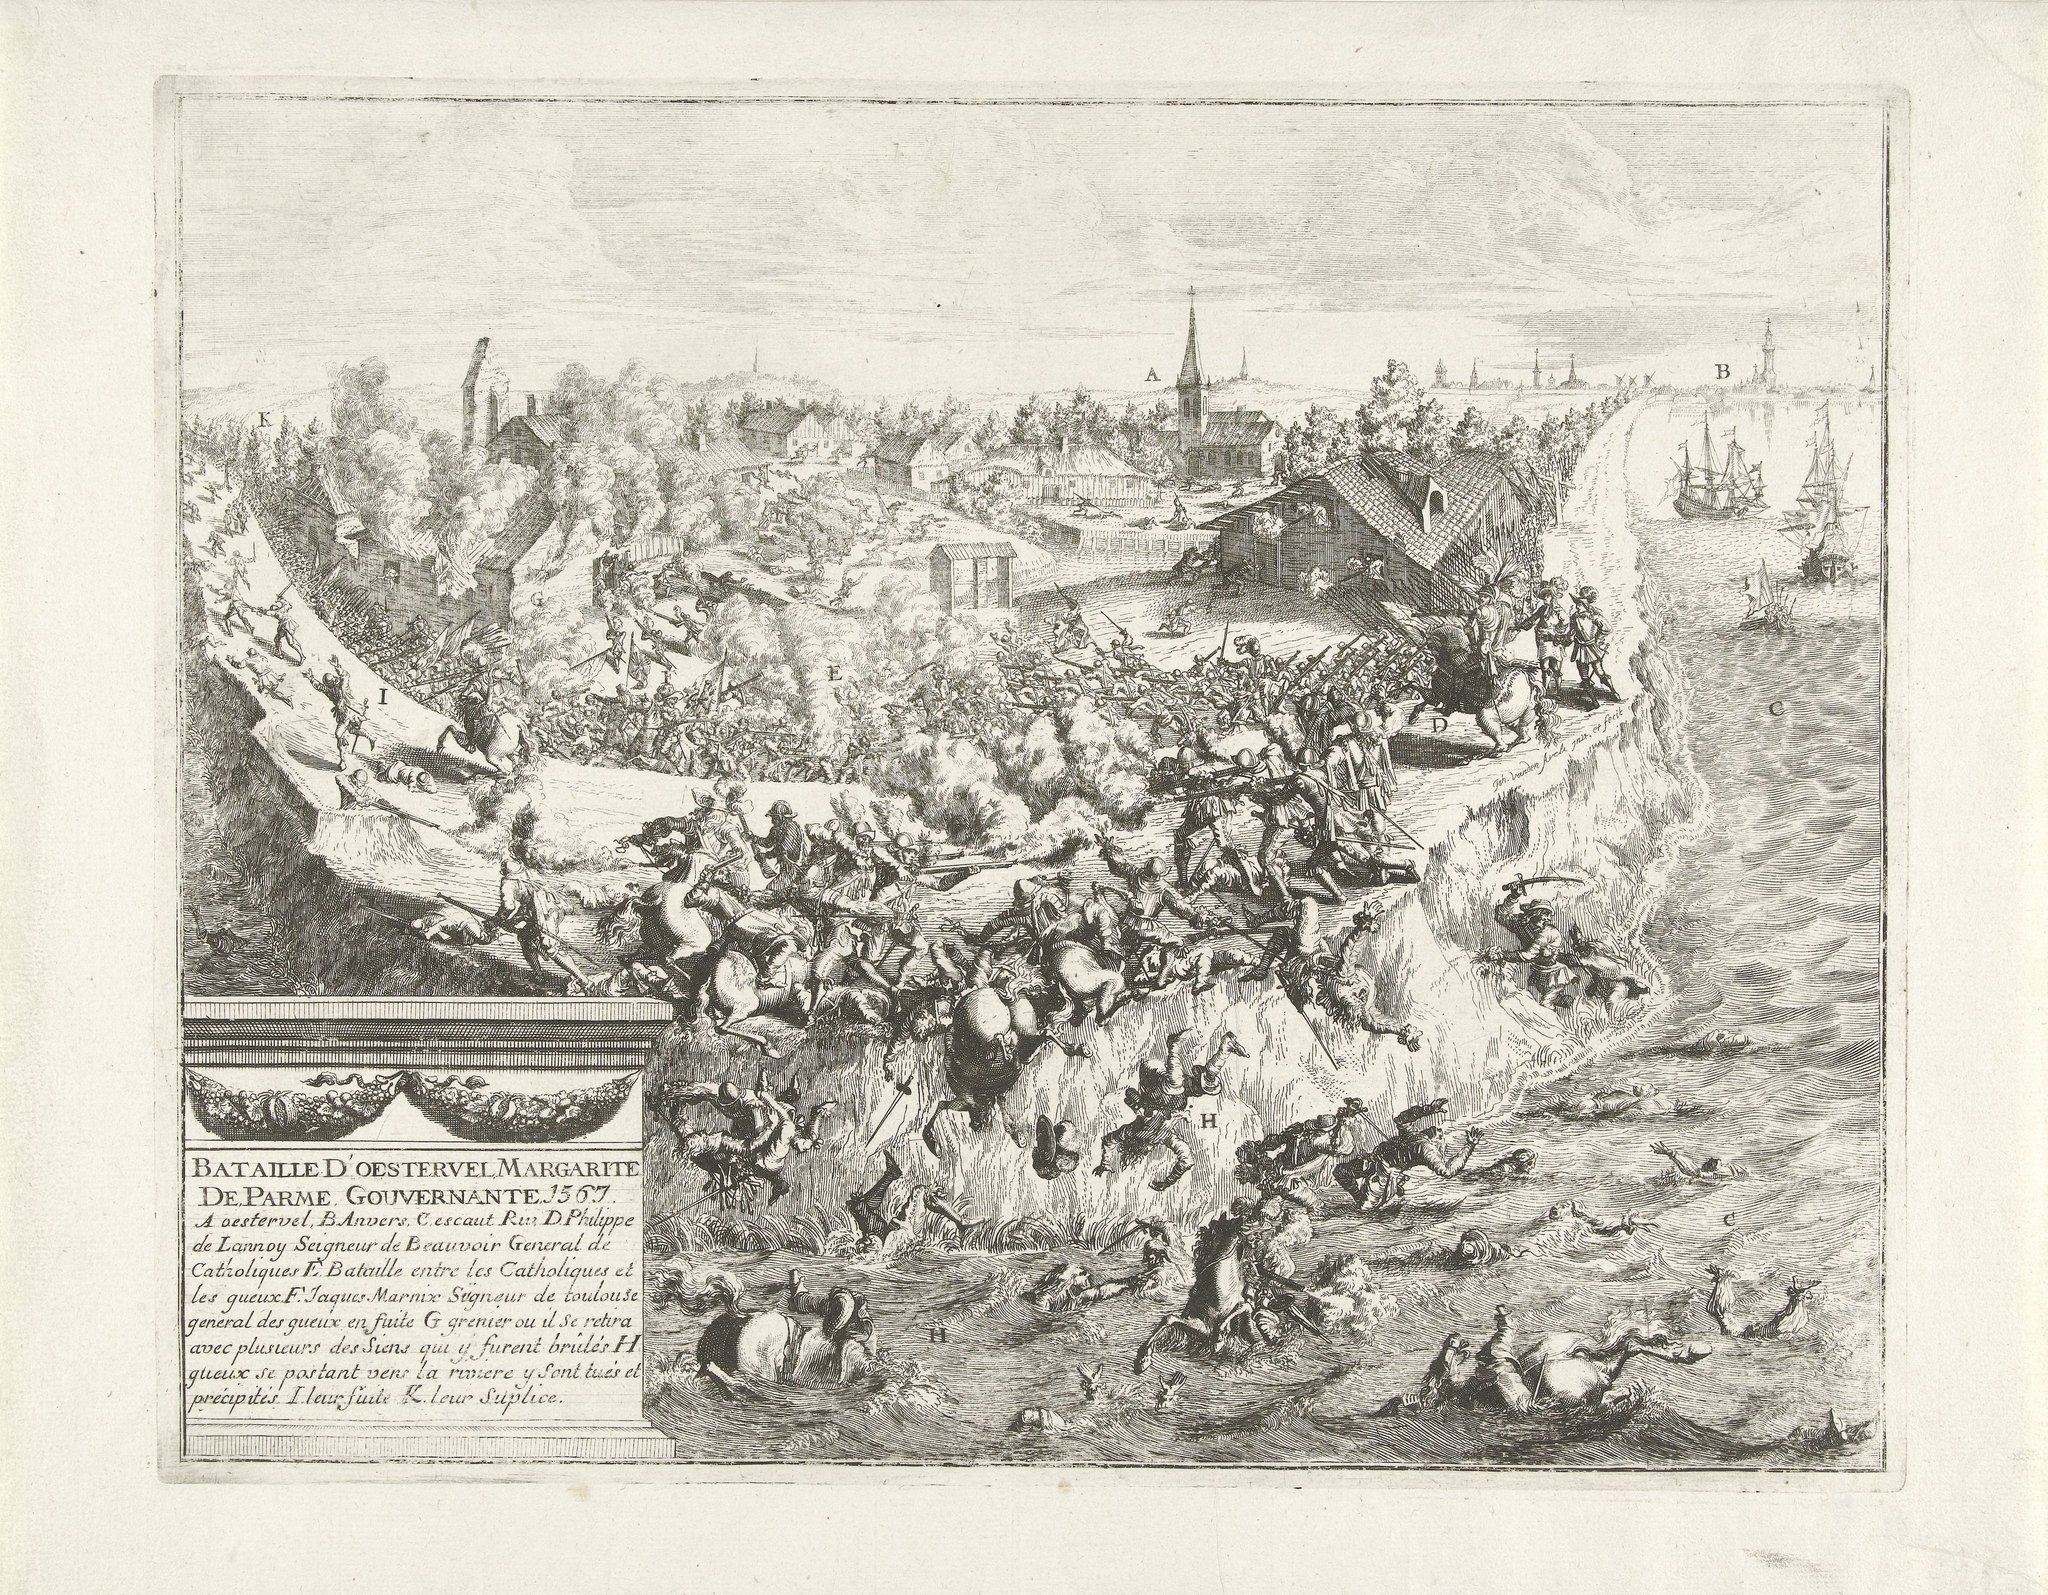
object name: history print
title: Bataille D'Oestervel, Margarite de Parme Gouvernante 1567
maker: johannes jacobsz van den aveele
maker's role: print maker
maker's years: 1655-1727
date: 1665-1727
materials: paper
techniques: etching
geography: northern netherlands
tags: battle, fighting in general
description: Slag bij Oosterweel, 13 maart 1567. De gevechten voor het dorpje Oosterweel buiten Antwerpen. De calvinisten onder leiding van Jan van Marnix worden verslagen door de troepen van de hertog van Aremberg en Philips van Lanoy. Rechts de Schelde. Linksonder een cartouche met de titel en de legenda A-K in het Frans.